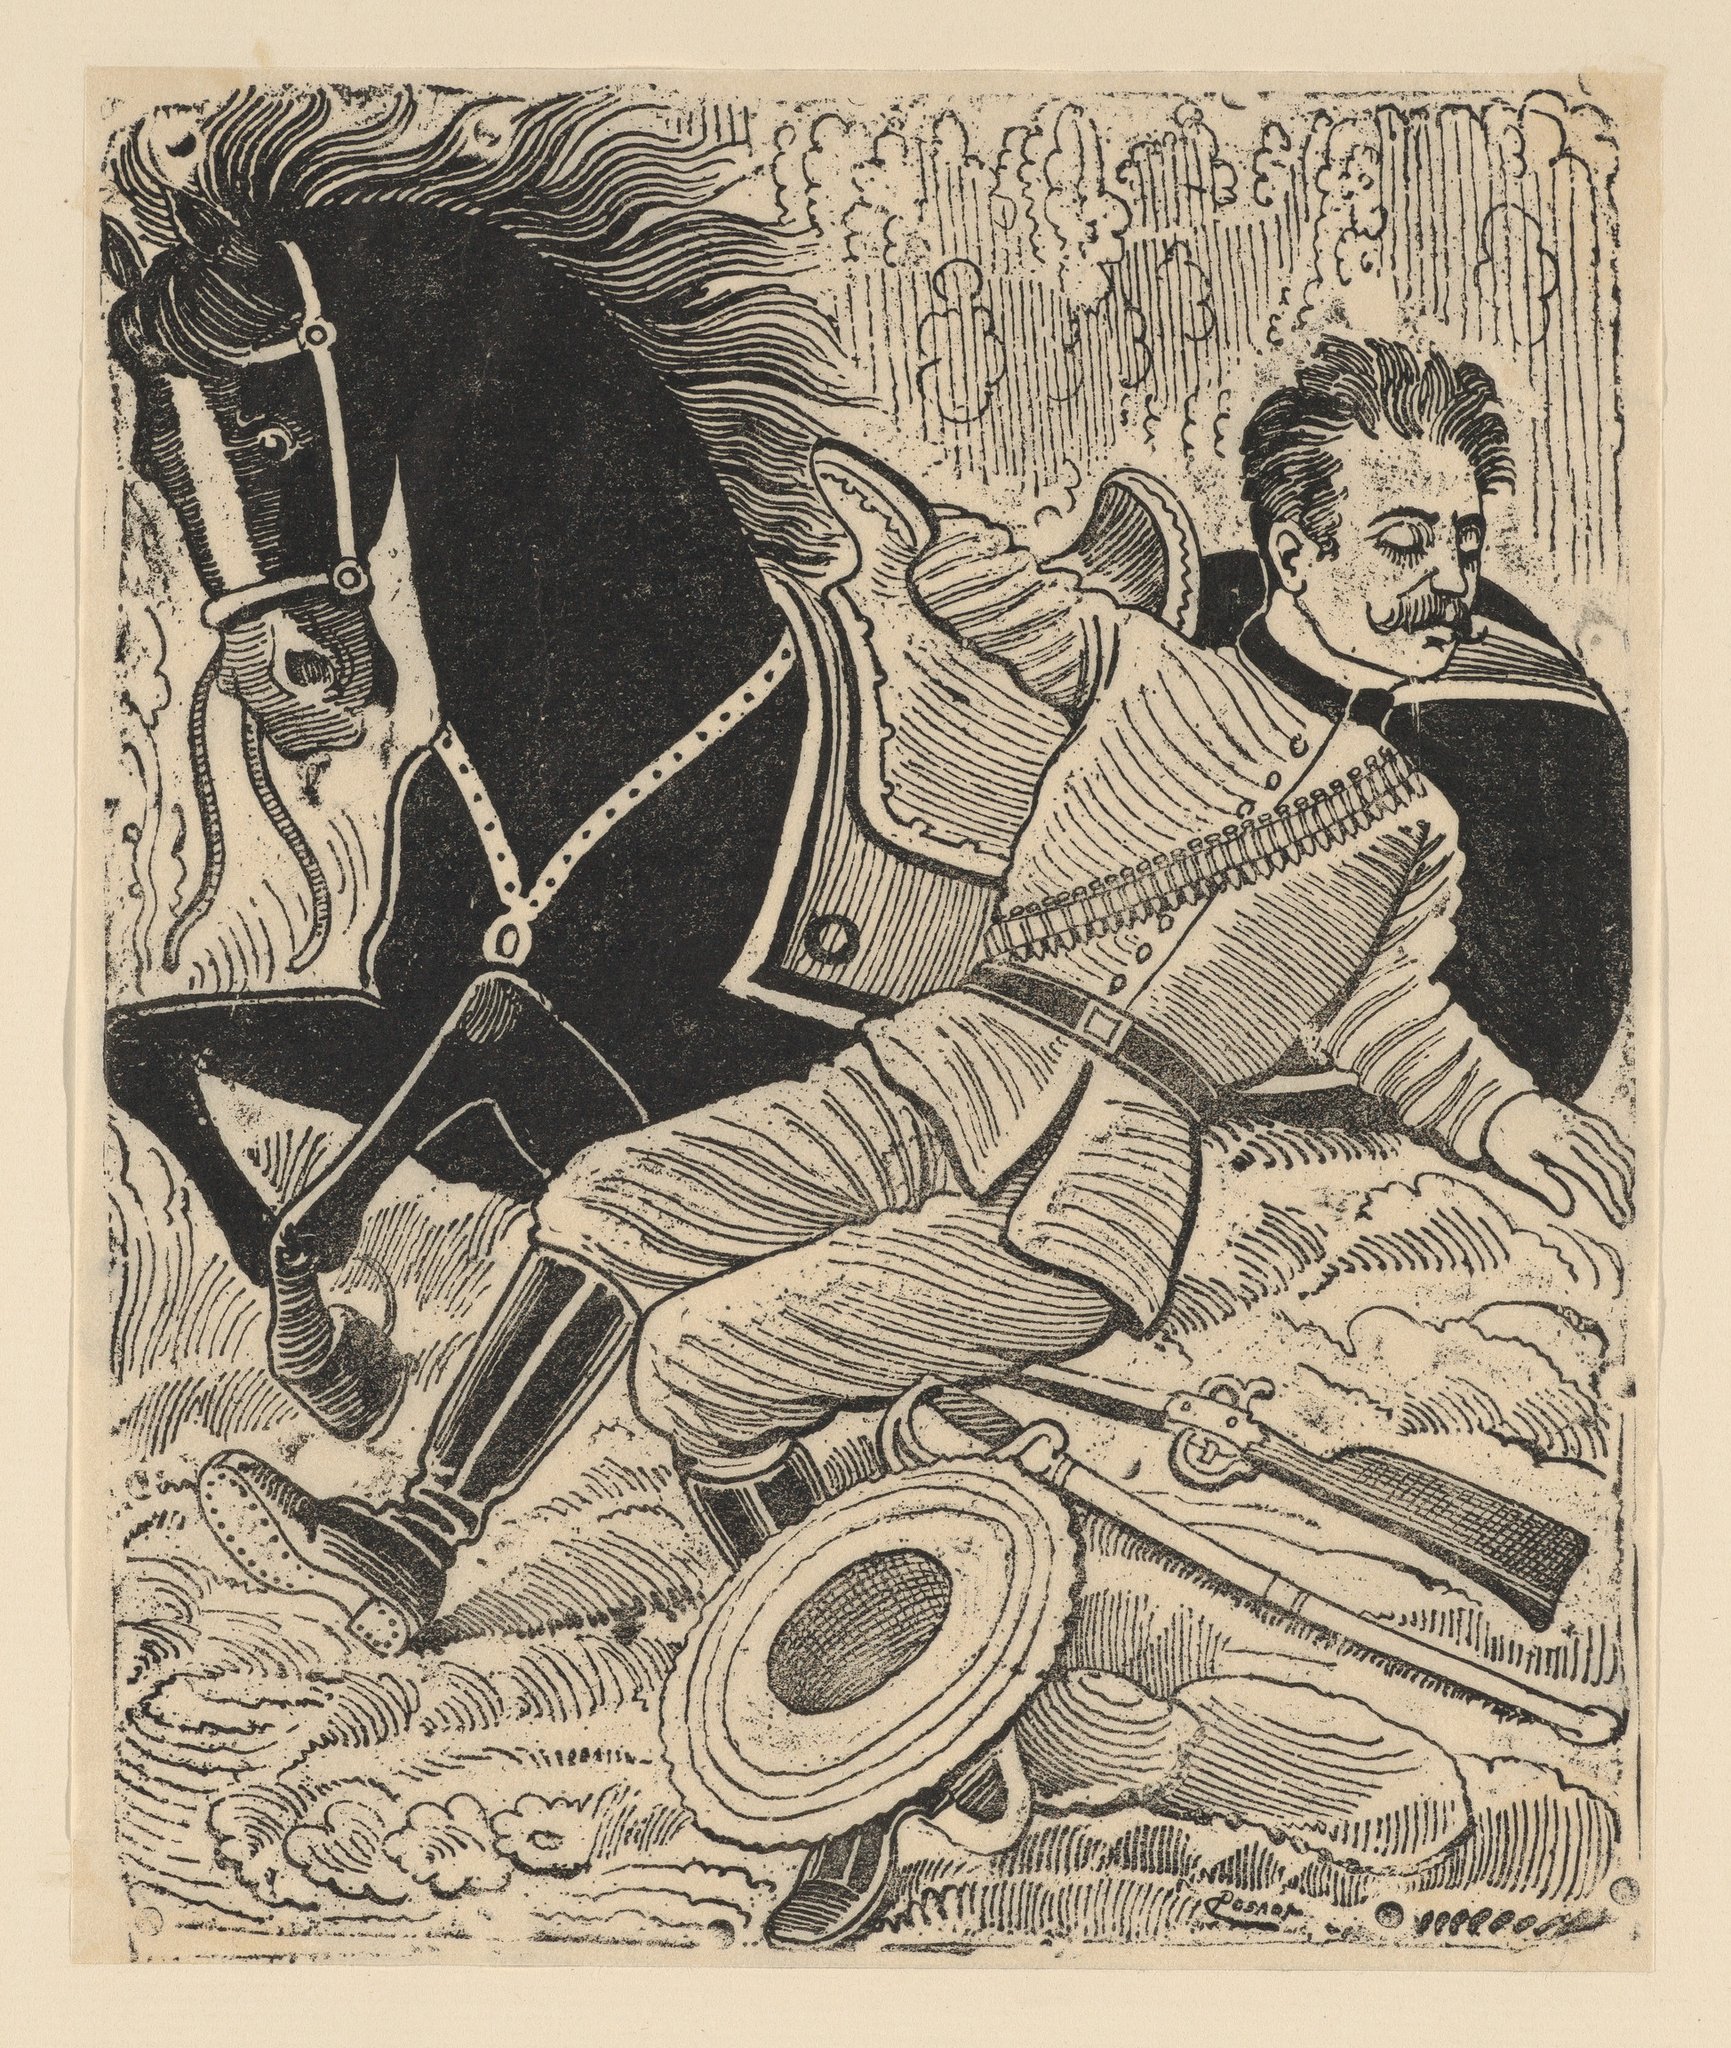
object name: print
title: A soldier fallen from his horse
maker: josé guadalupe posada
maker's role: artist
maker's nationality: mexican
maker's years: 1852-1913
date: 1911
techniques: lithography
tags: soldiers,weapons,horses,death